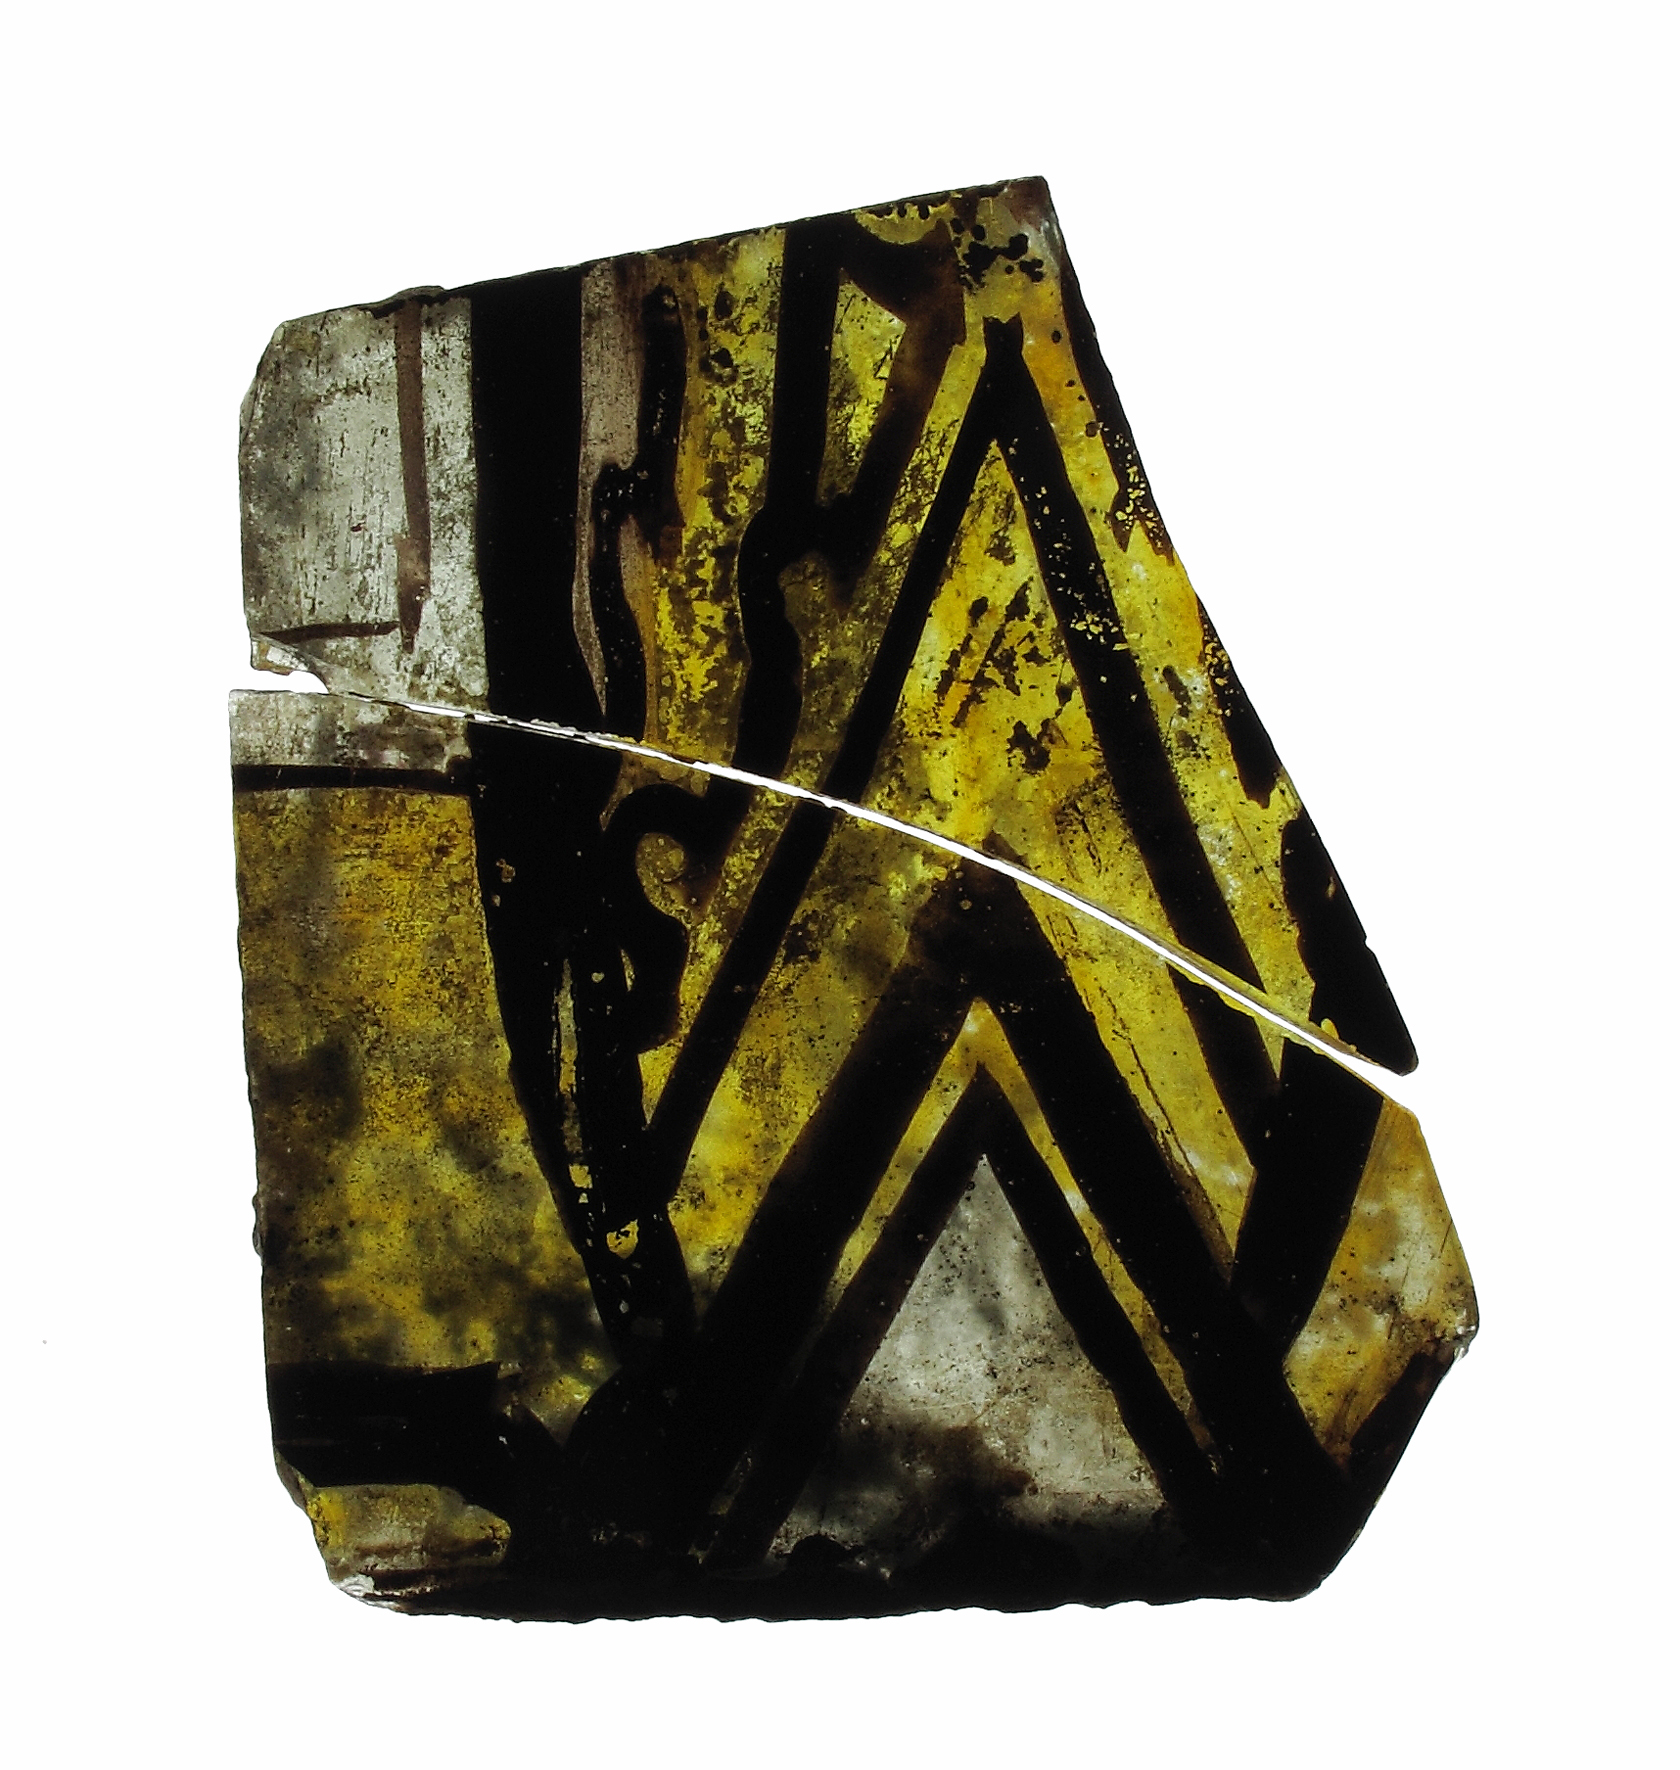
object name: fragment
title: Glass Fragment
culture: british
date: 1301-1400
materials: glass